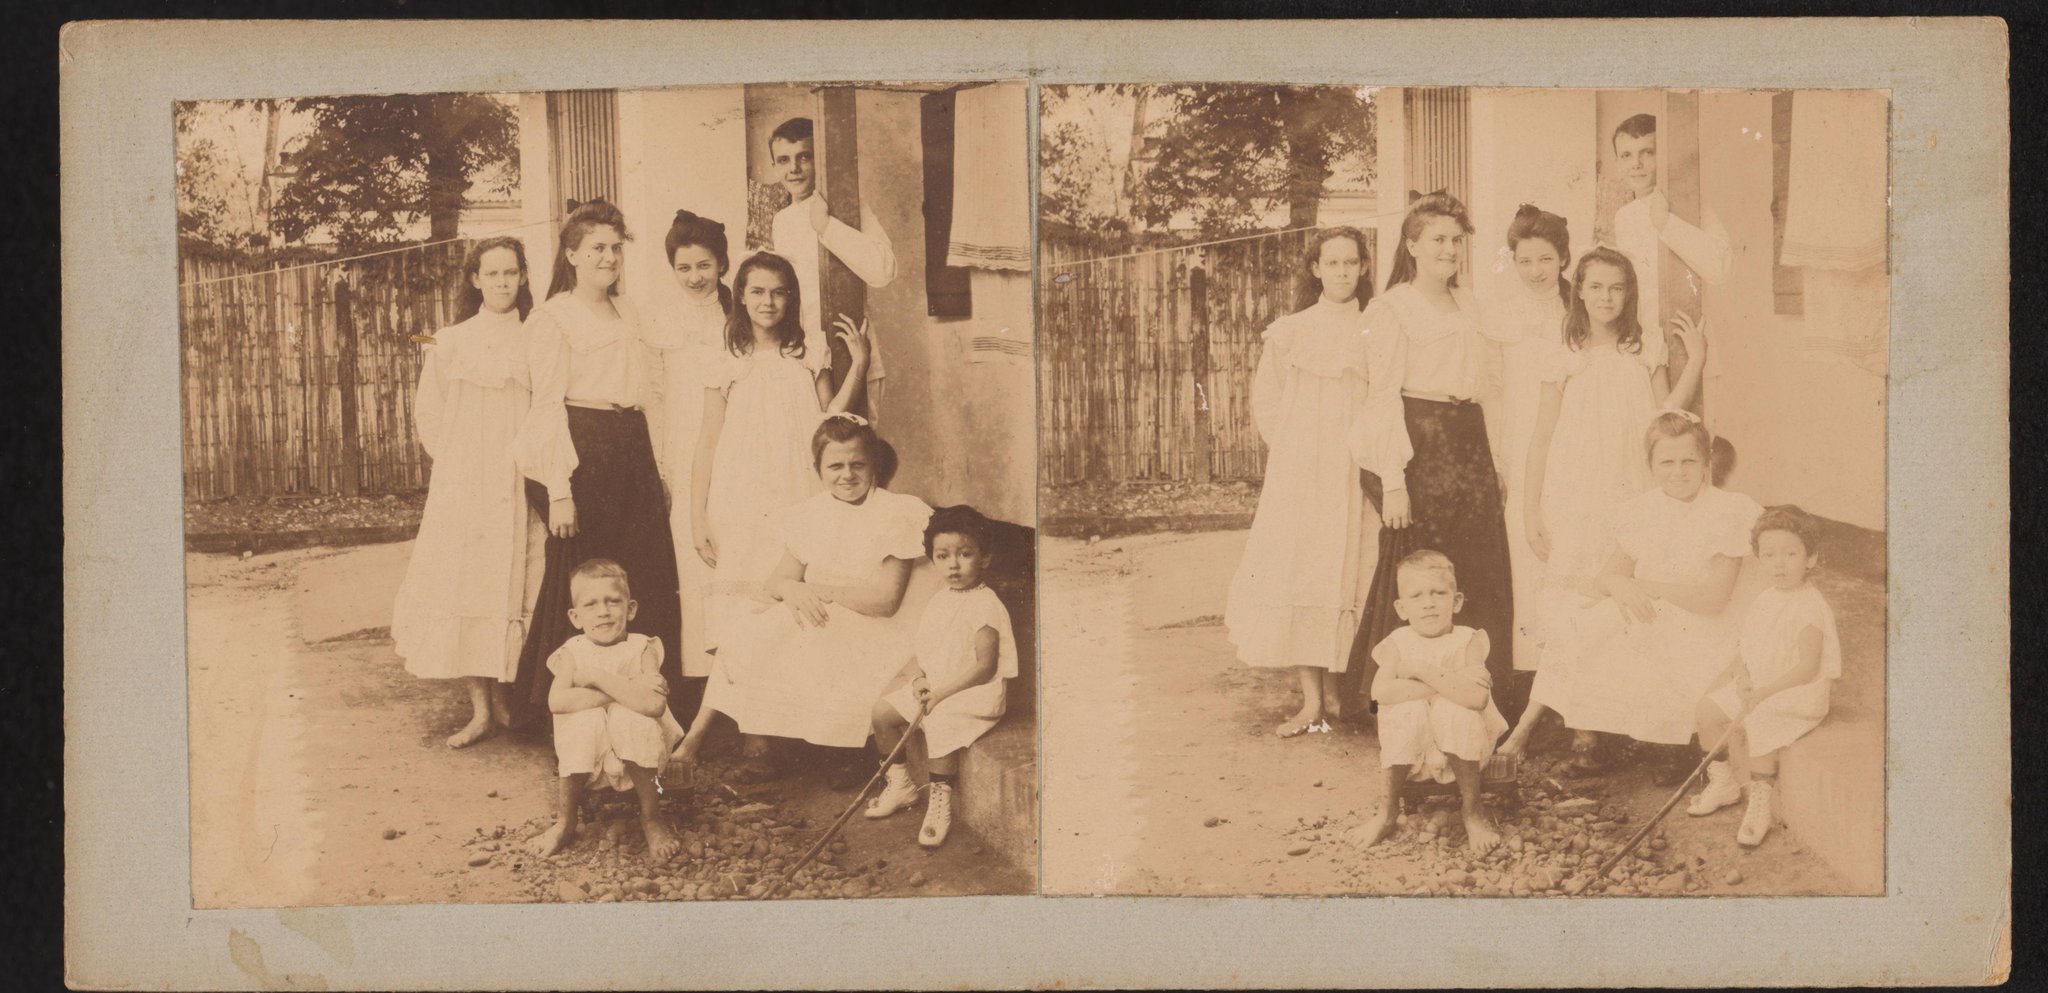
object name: stereograph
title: Groep kinderen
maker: robert julius boers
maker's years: 1867-1932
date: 1900-1922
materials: cardboard, photographic support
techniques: gelatin silver print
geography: bangka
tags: robert julius boers, dutch east indies, the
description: Portret van een groep Europese kinderen bij een huis, waarschijnlijk te Banka. Onderdeel van een groep stereofoto's van Robert Julius Boers, chef van het staatsbedrijf de Banka-tinwinning op Banka, uit de periode ca. 1900-1922.